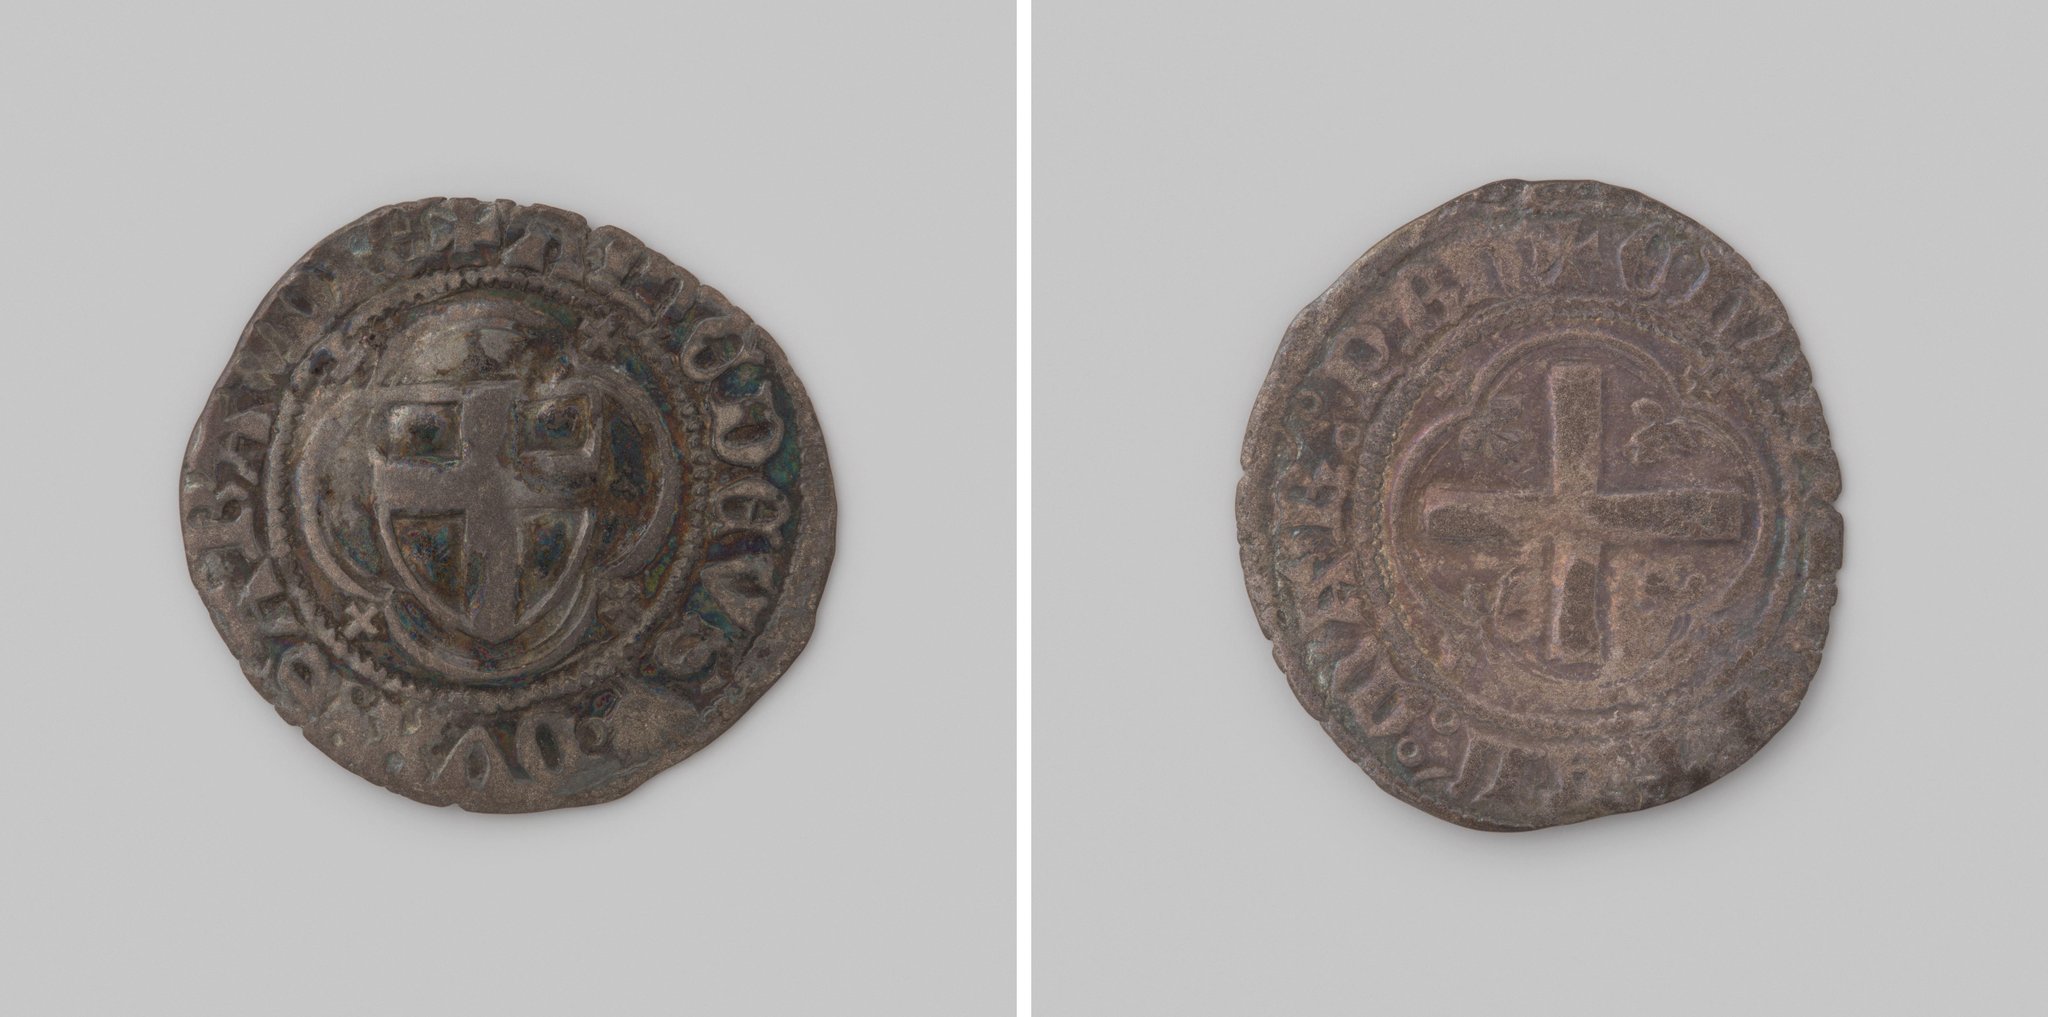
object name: coin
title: Grosso of obolo bianco uit Savoye van hertog Amedeo VIII, 1391-1439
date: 1416-1439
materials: silver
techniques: striking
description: Zilveren munt. Voorzijde: binnen een vierpas het wapenschild van Savoye. Keerzijde: binnen een vierpas kort kruis met in de hoeken blaadjes.